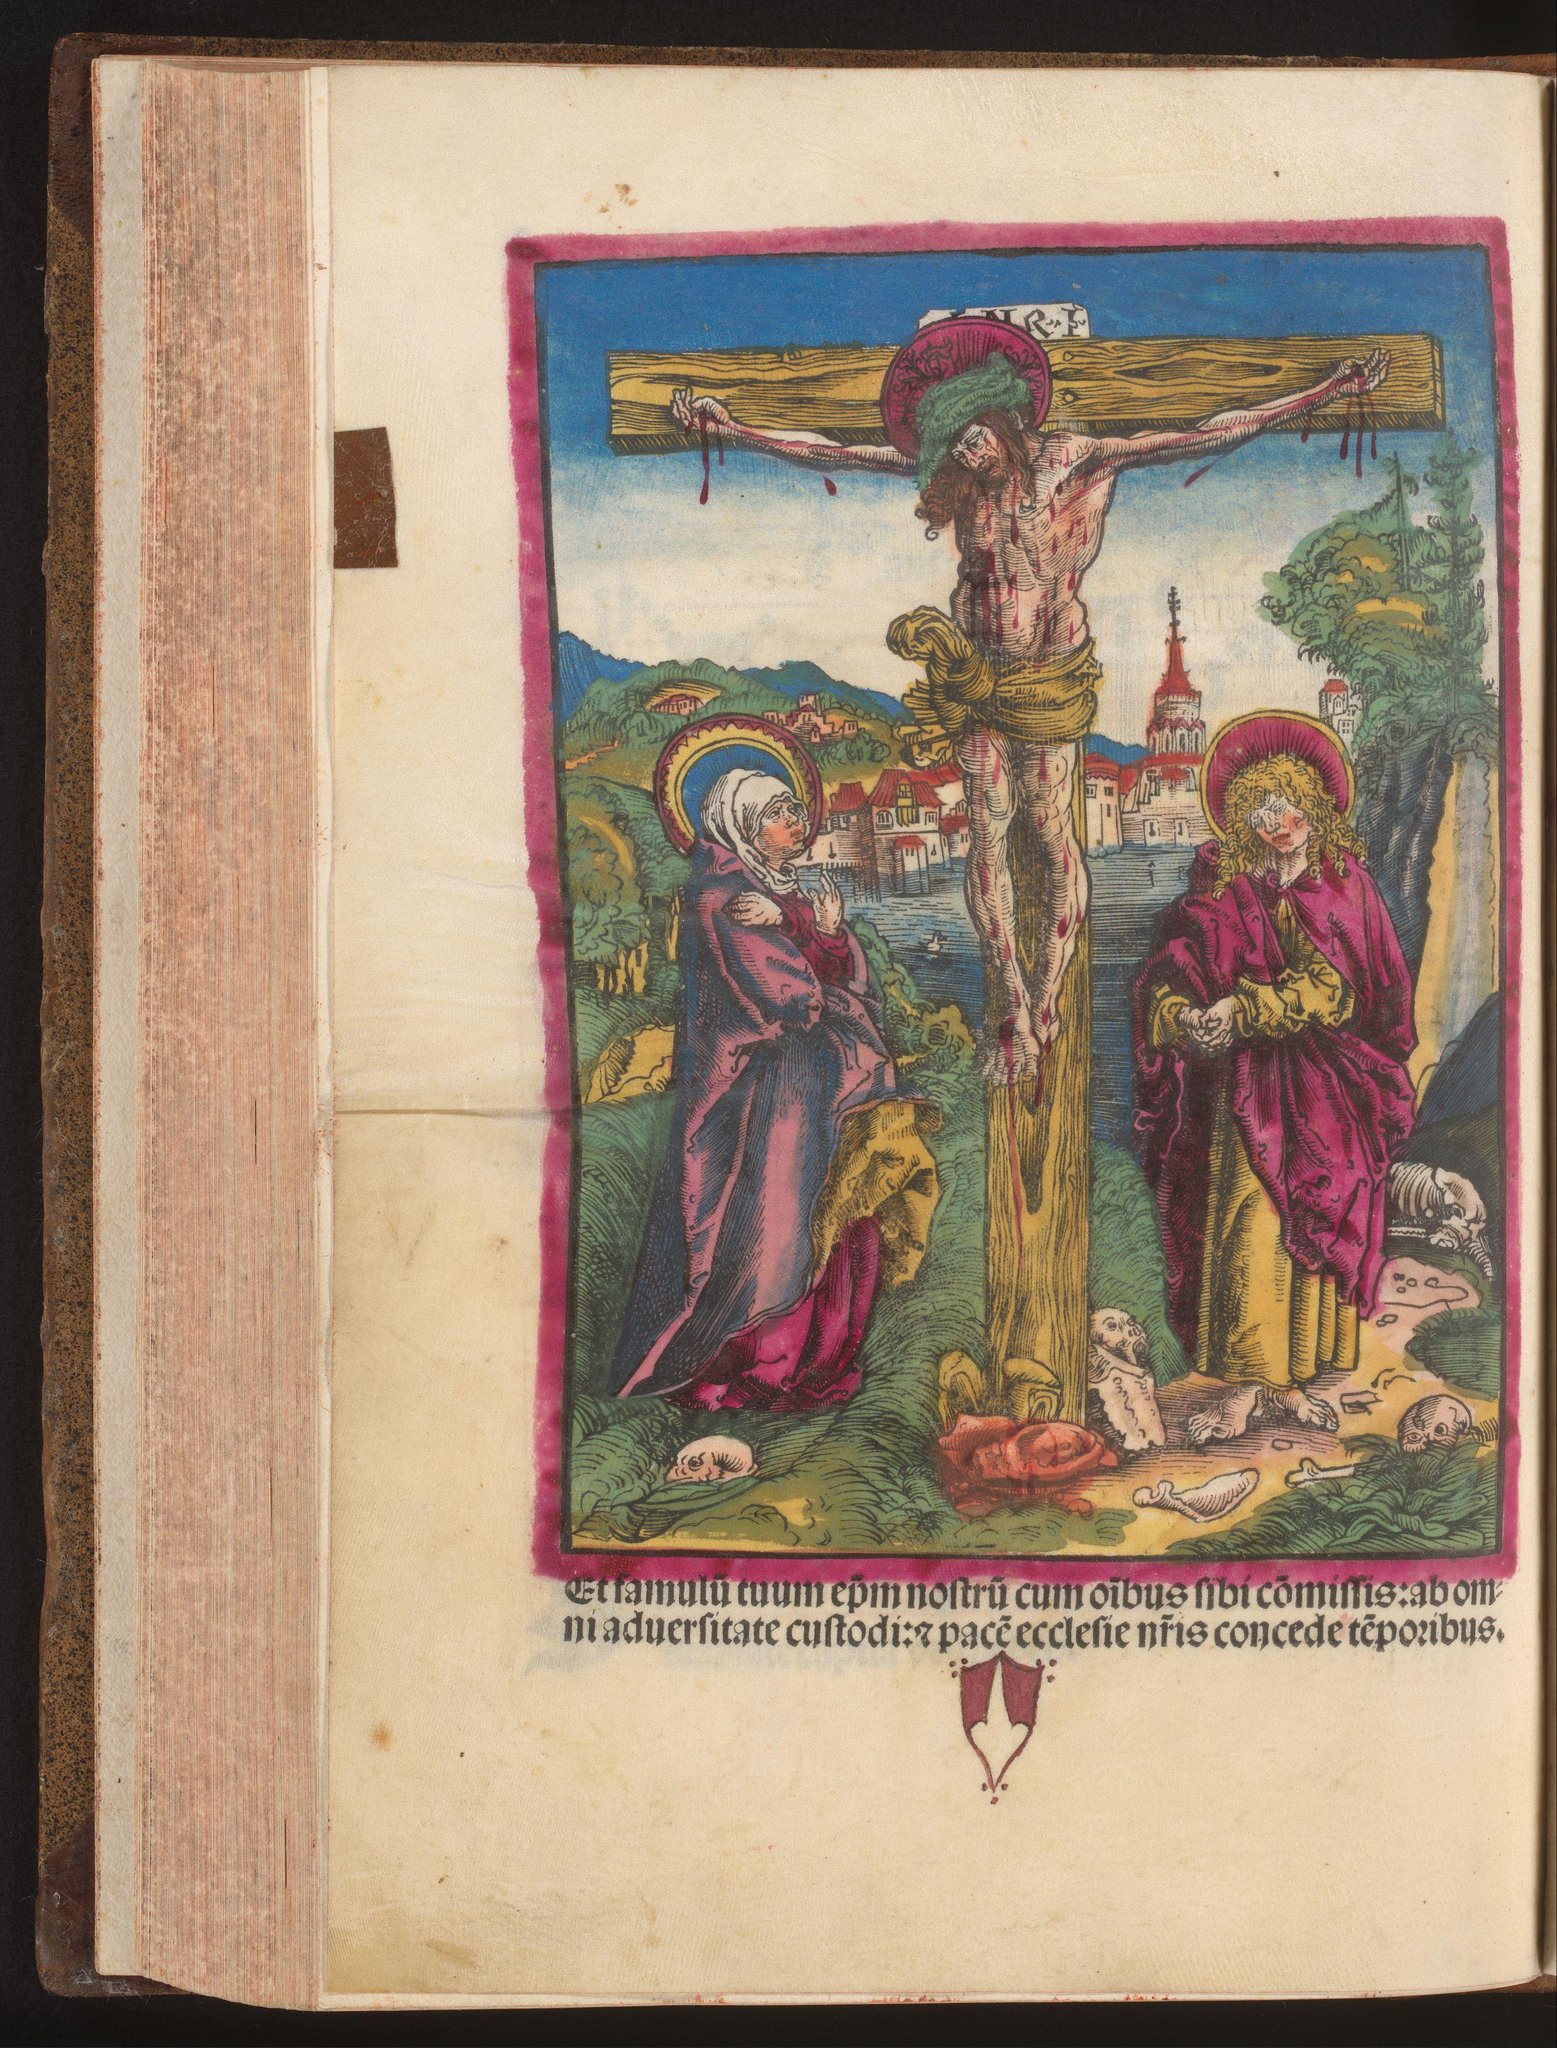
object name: print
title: Christus aan het kruis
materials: parchment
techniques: hand coloring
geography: vienna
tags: crucified christ with mary and john on either side of the cross; holy rood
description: Onder het kruis Maria en de H. Johannes (Koepplin-Falk I, nr. 64). Prent uit Missaal Pataviense, 1503.